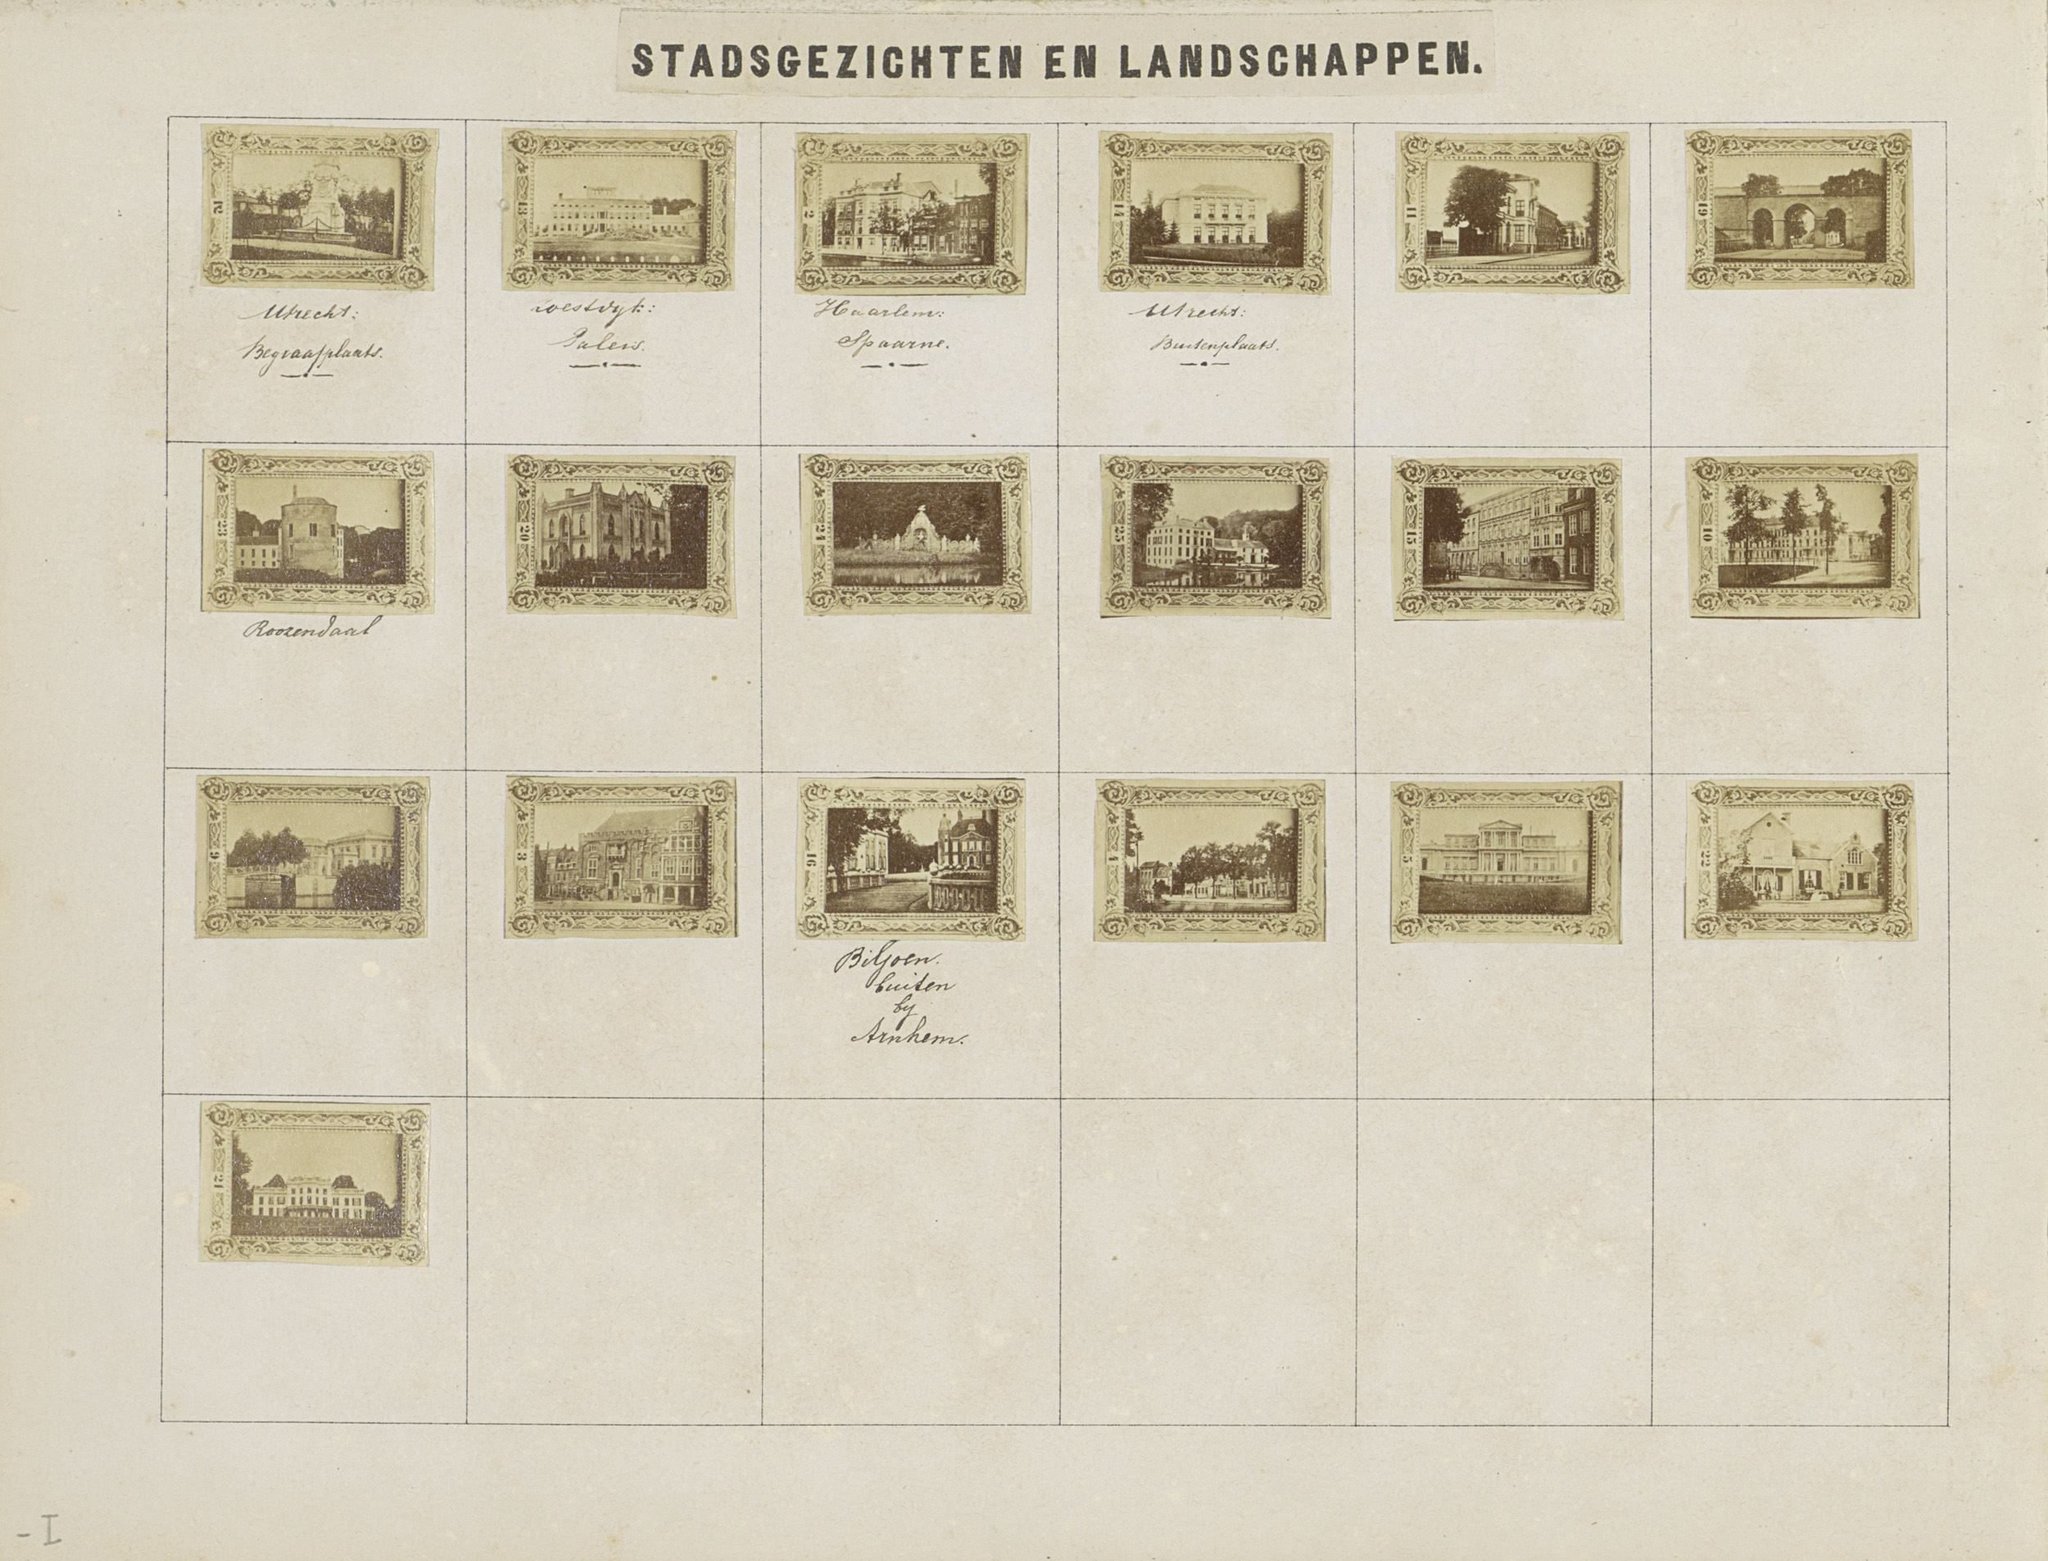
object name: photograph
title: Stadsgezichten en landschappen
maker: Anonymous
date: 1872-1875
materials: paper, photographic support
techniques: albumen print, writing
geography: haarlem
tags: towers ~ fortified city, palace, villa, exterior ~ representation of a building, cemetery, park-like burying ground, city-gate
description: Onderdeel van Regnib's miniaturenalbum van vorsten, beroemdheden en historische en fantasietaferelen.